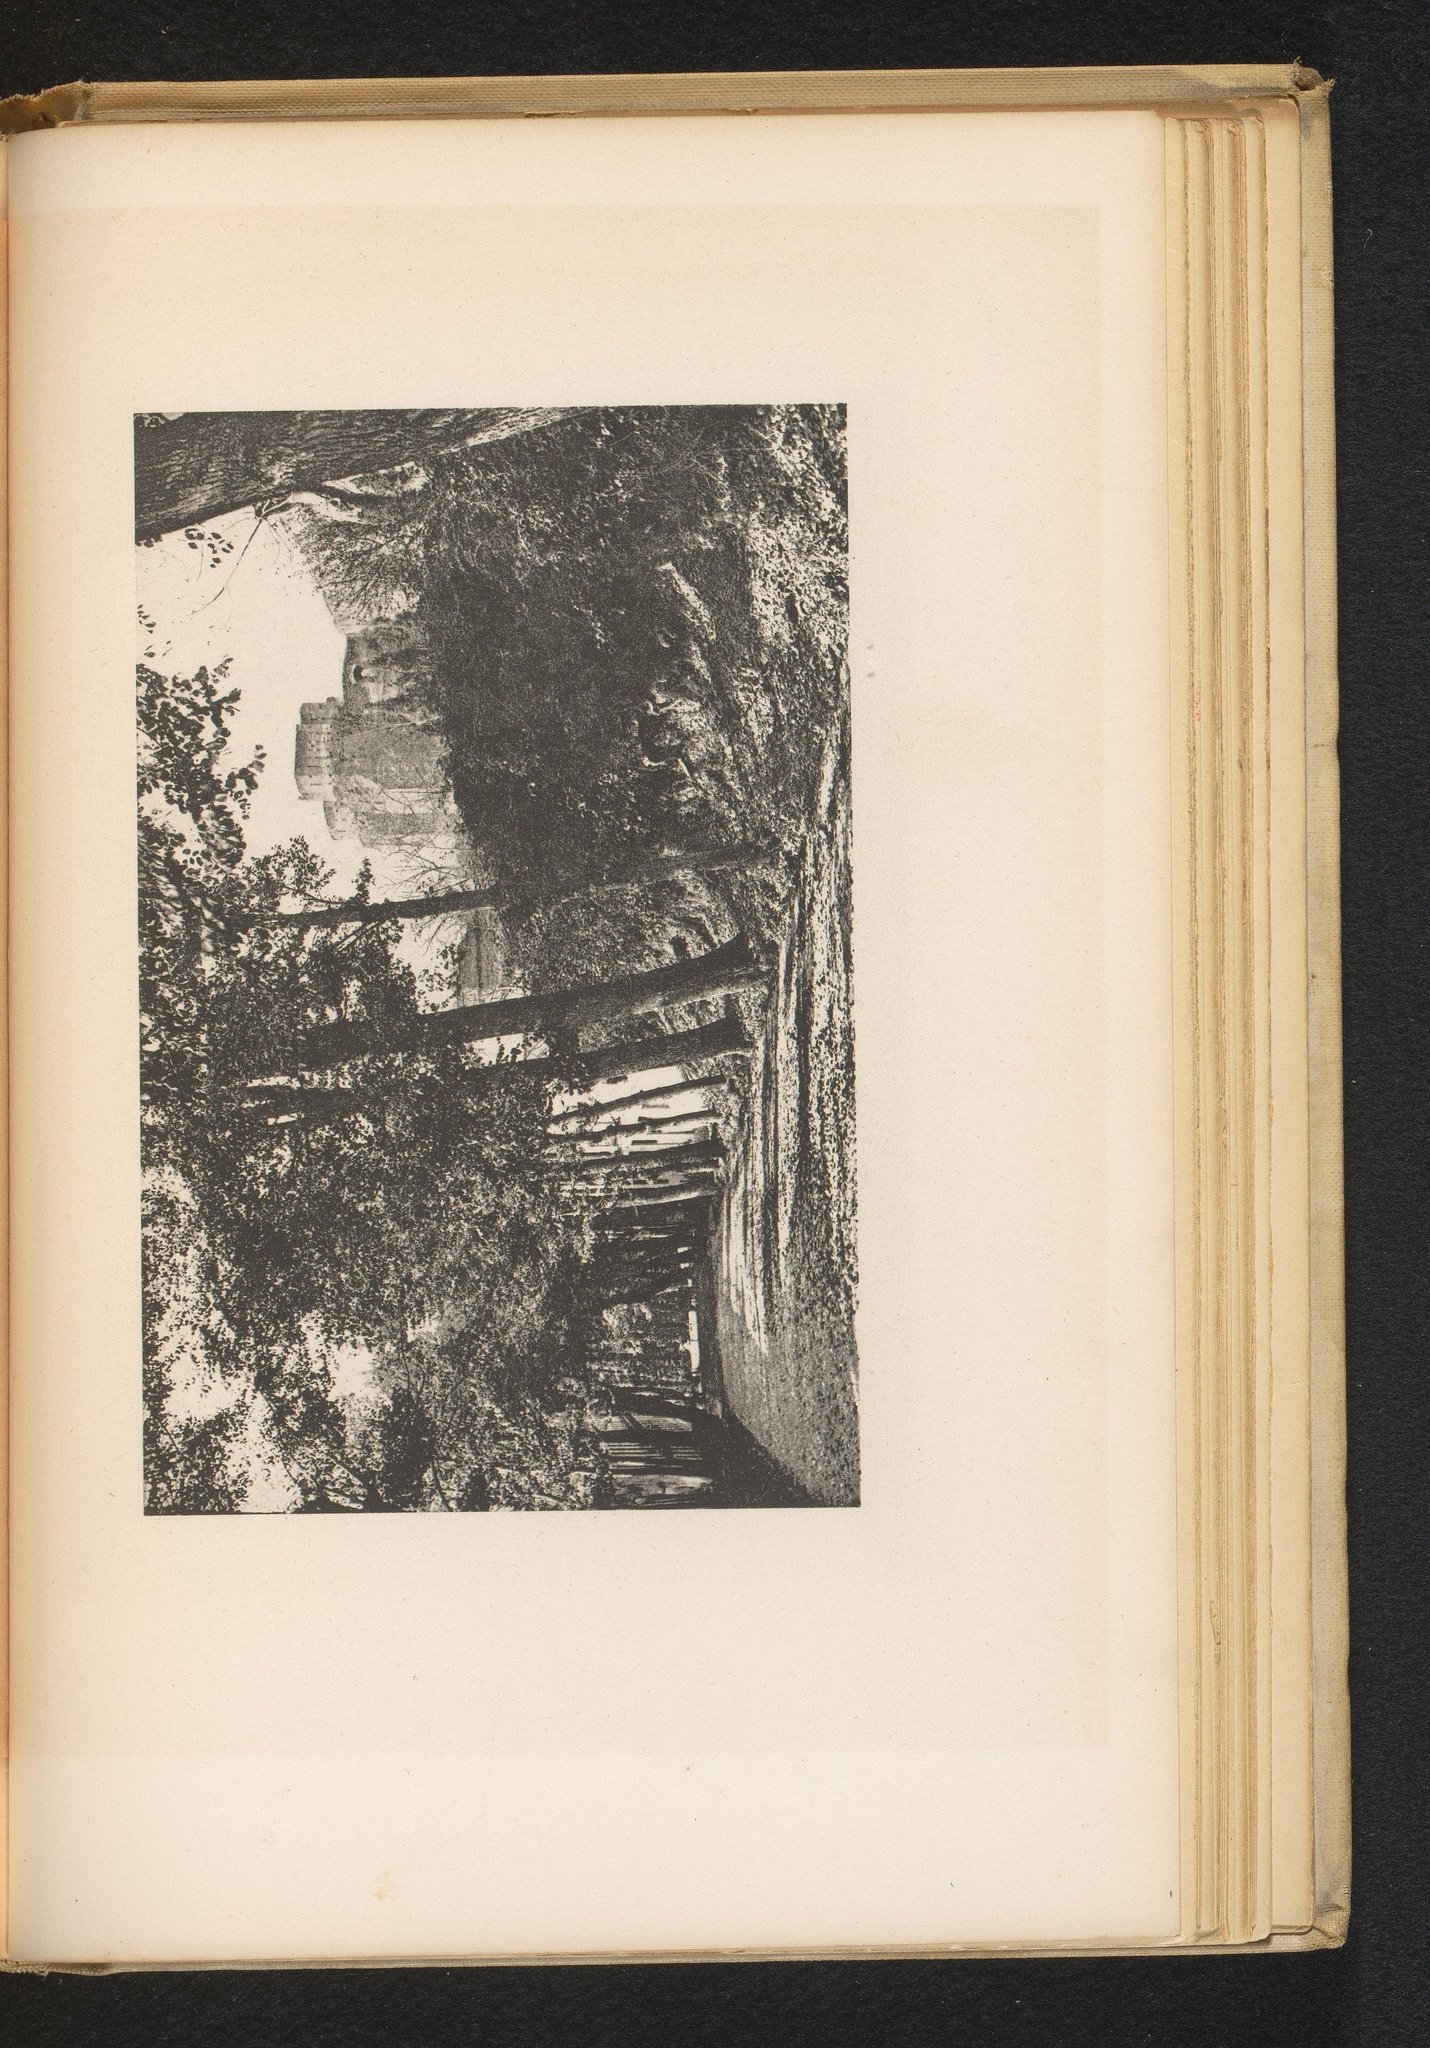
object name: page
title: Gezicht op de Torre de los Siete Suelos van het Alhambra vanaf een laan met bomen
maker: Anonymous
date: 1884-1894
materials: paper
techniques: photoaquatint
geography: alhambra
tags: tower, clock tower ~ monumental adornment, lane, alley